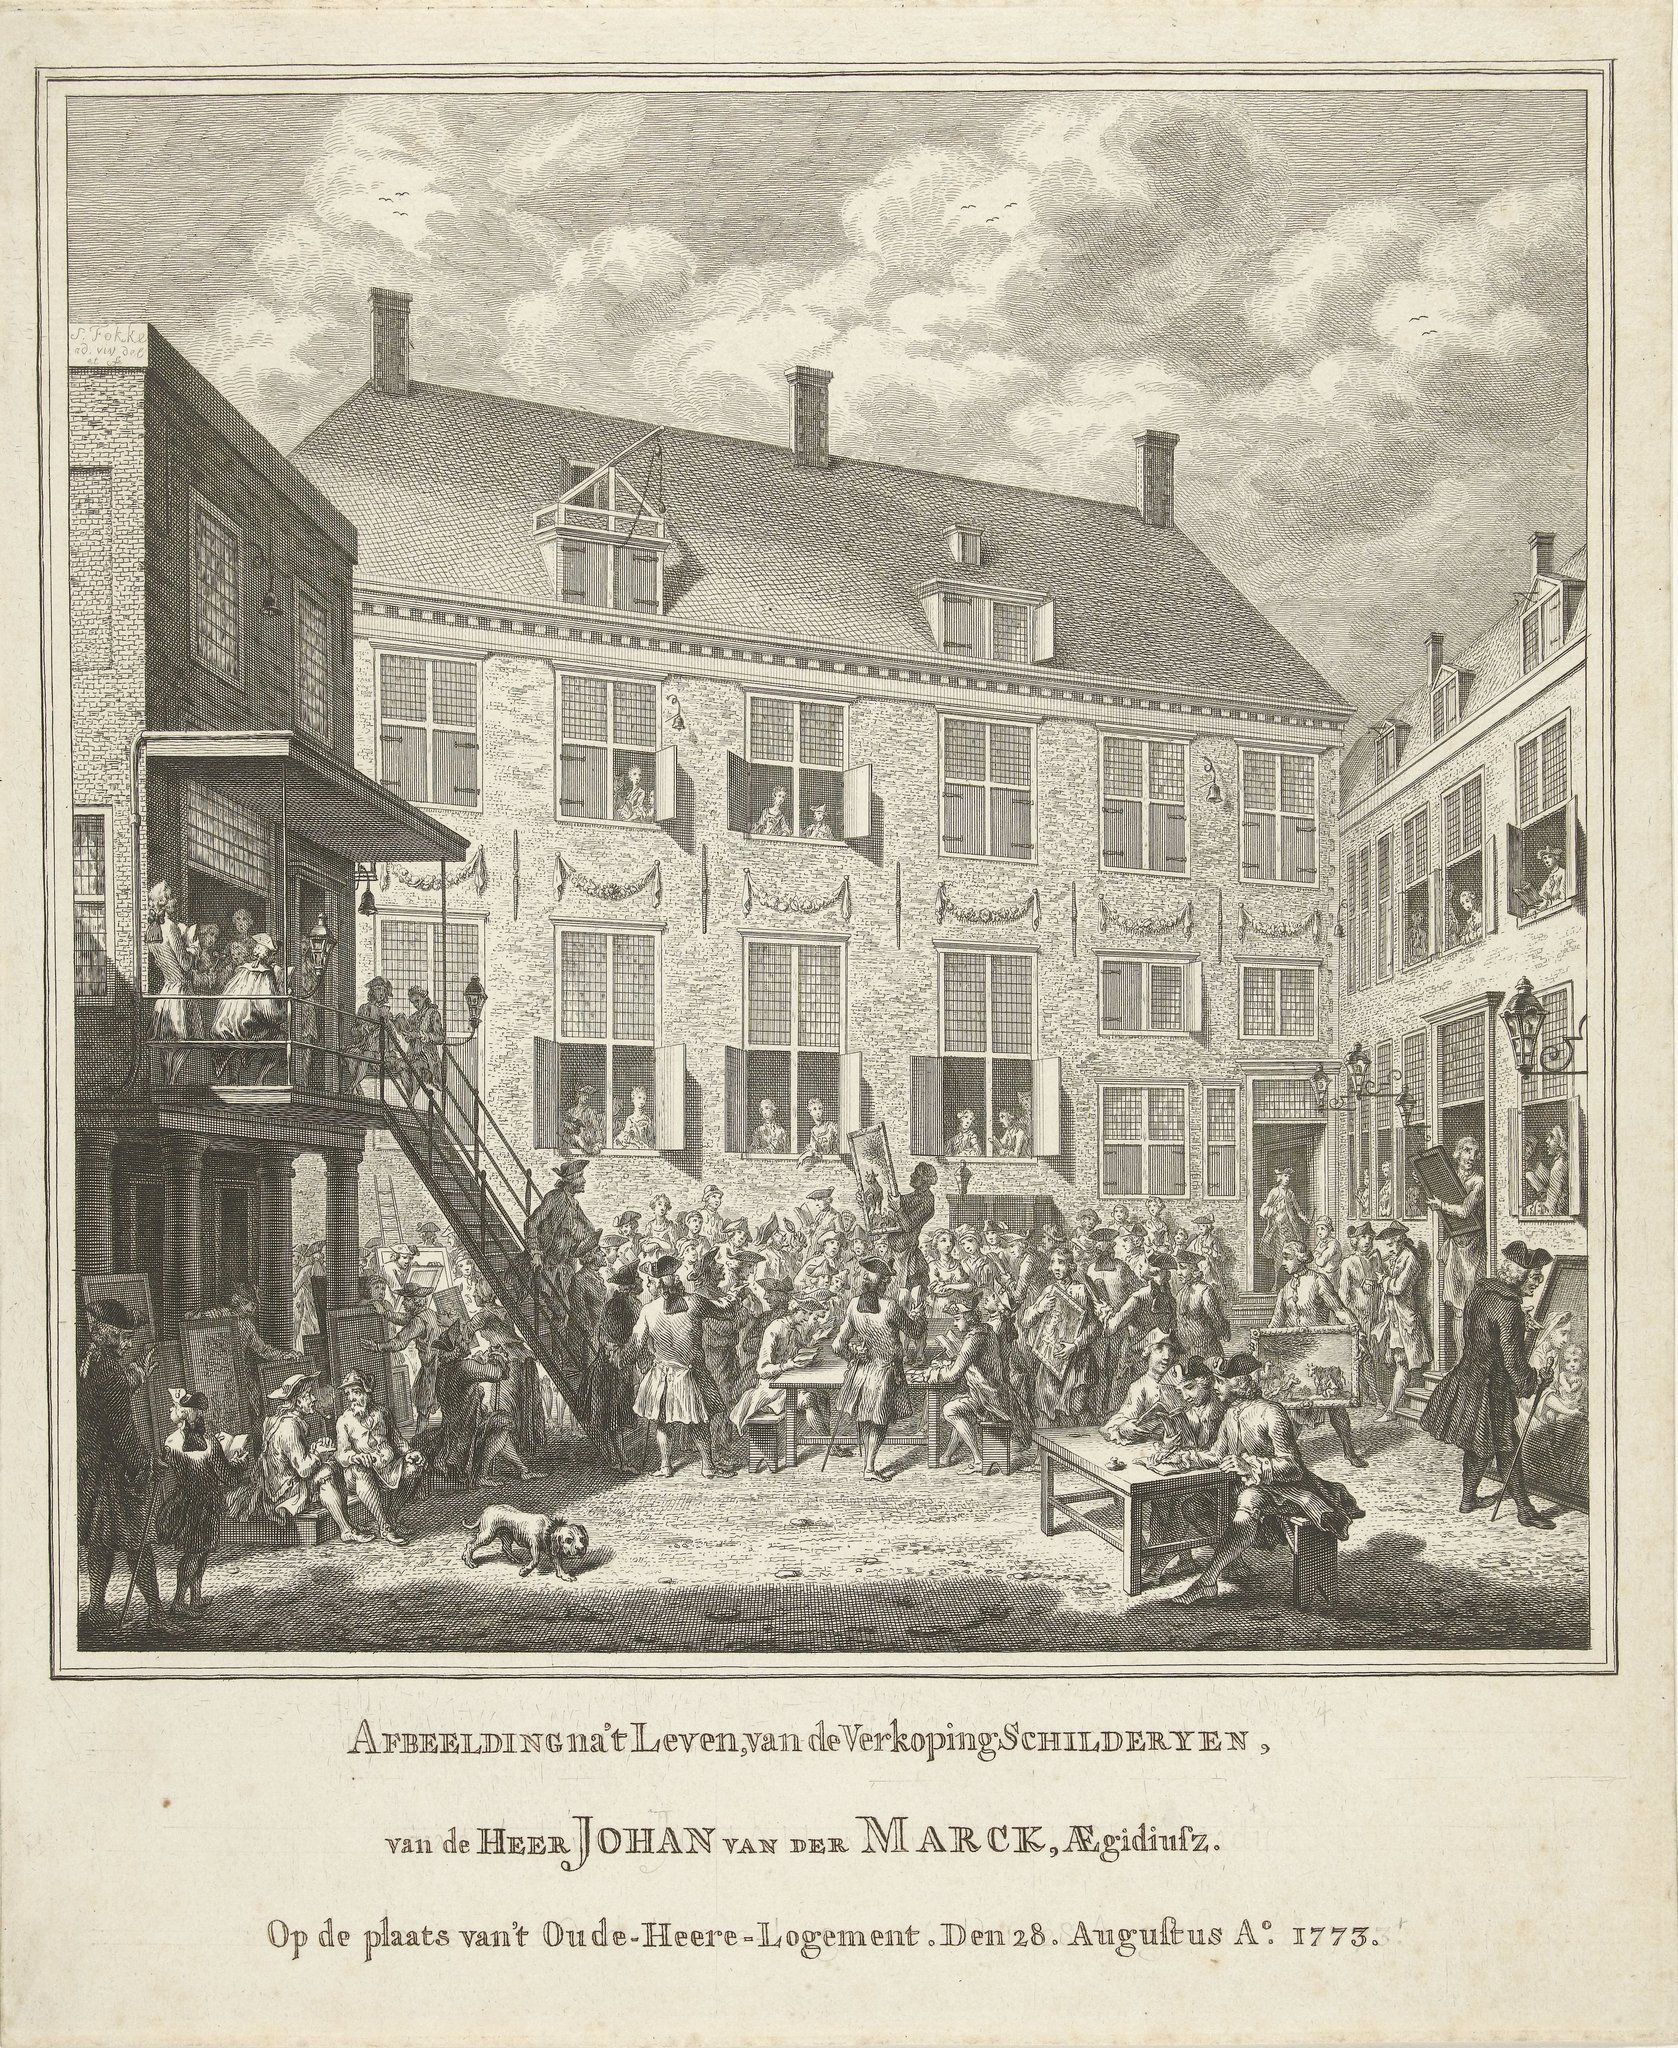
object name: print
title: Gezicht op het Oudezijds Herenlogement te Amsterdam en een schilderijenverkoop, 1773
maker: simon fokke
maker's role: draughtsman, print maker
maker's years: 1712-1784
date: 1774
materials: paper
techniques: etching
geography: amsterdam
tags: art sale, auction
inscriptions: collector's mark: Lugt 2233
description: Gezicht op de binnenplaats van het Oudezijds Herenlogement te Amsterdam waar een schilderijenverkoop plaatsvindt. Waarschijnlijk betreft het de openbare verkoop of veiling van de schilderijenverzameling van de in 1772 overleden Leidse burgemeester Johan van der Markt Aegidsz. op 25 augustus 1773.